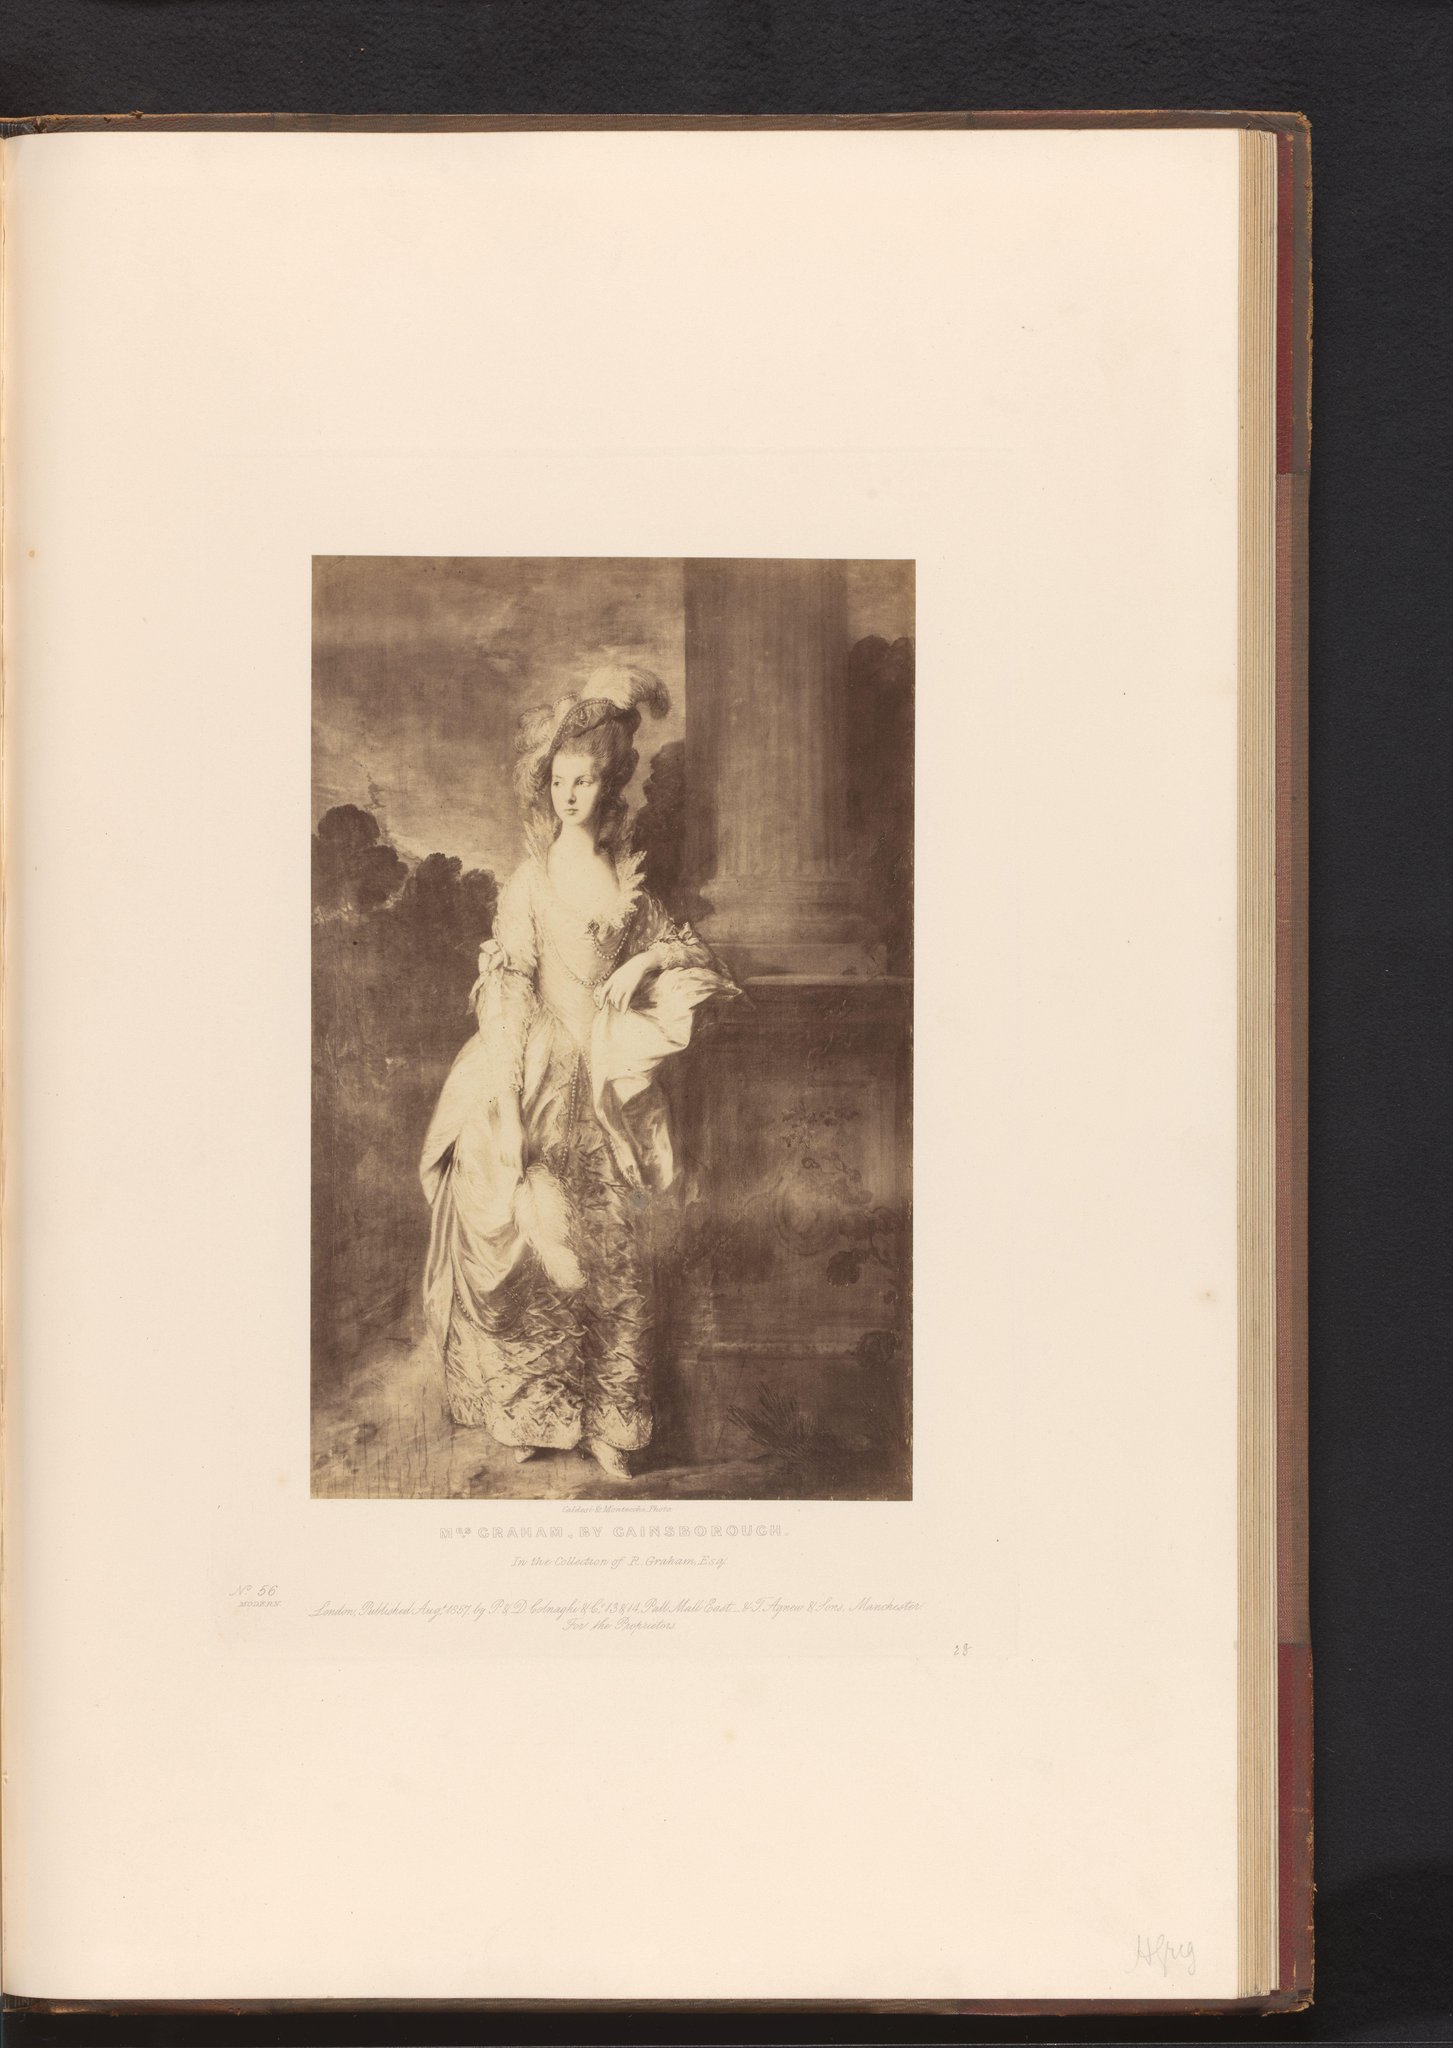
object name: photograph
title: Fotoreproductie van The Honourable Mrs Graham door Thomas Gainsborough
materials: photographic support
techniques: albumen print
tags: historical persons not known by name - bb - woman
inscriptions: inscription: ‘In the Collection of R. Graham, Esq./ London, Published Augt, 1857, by P. & D. Colnaghi & Co, 13 & 14, Pall Mall East & T. Agneur & Sons, Manchester./ For the Proprietors.’, annotation: ‘A[.]reg’, number: ‘28’, number: ‘No. 56./ MODERN.’